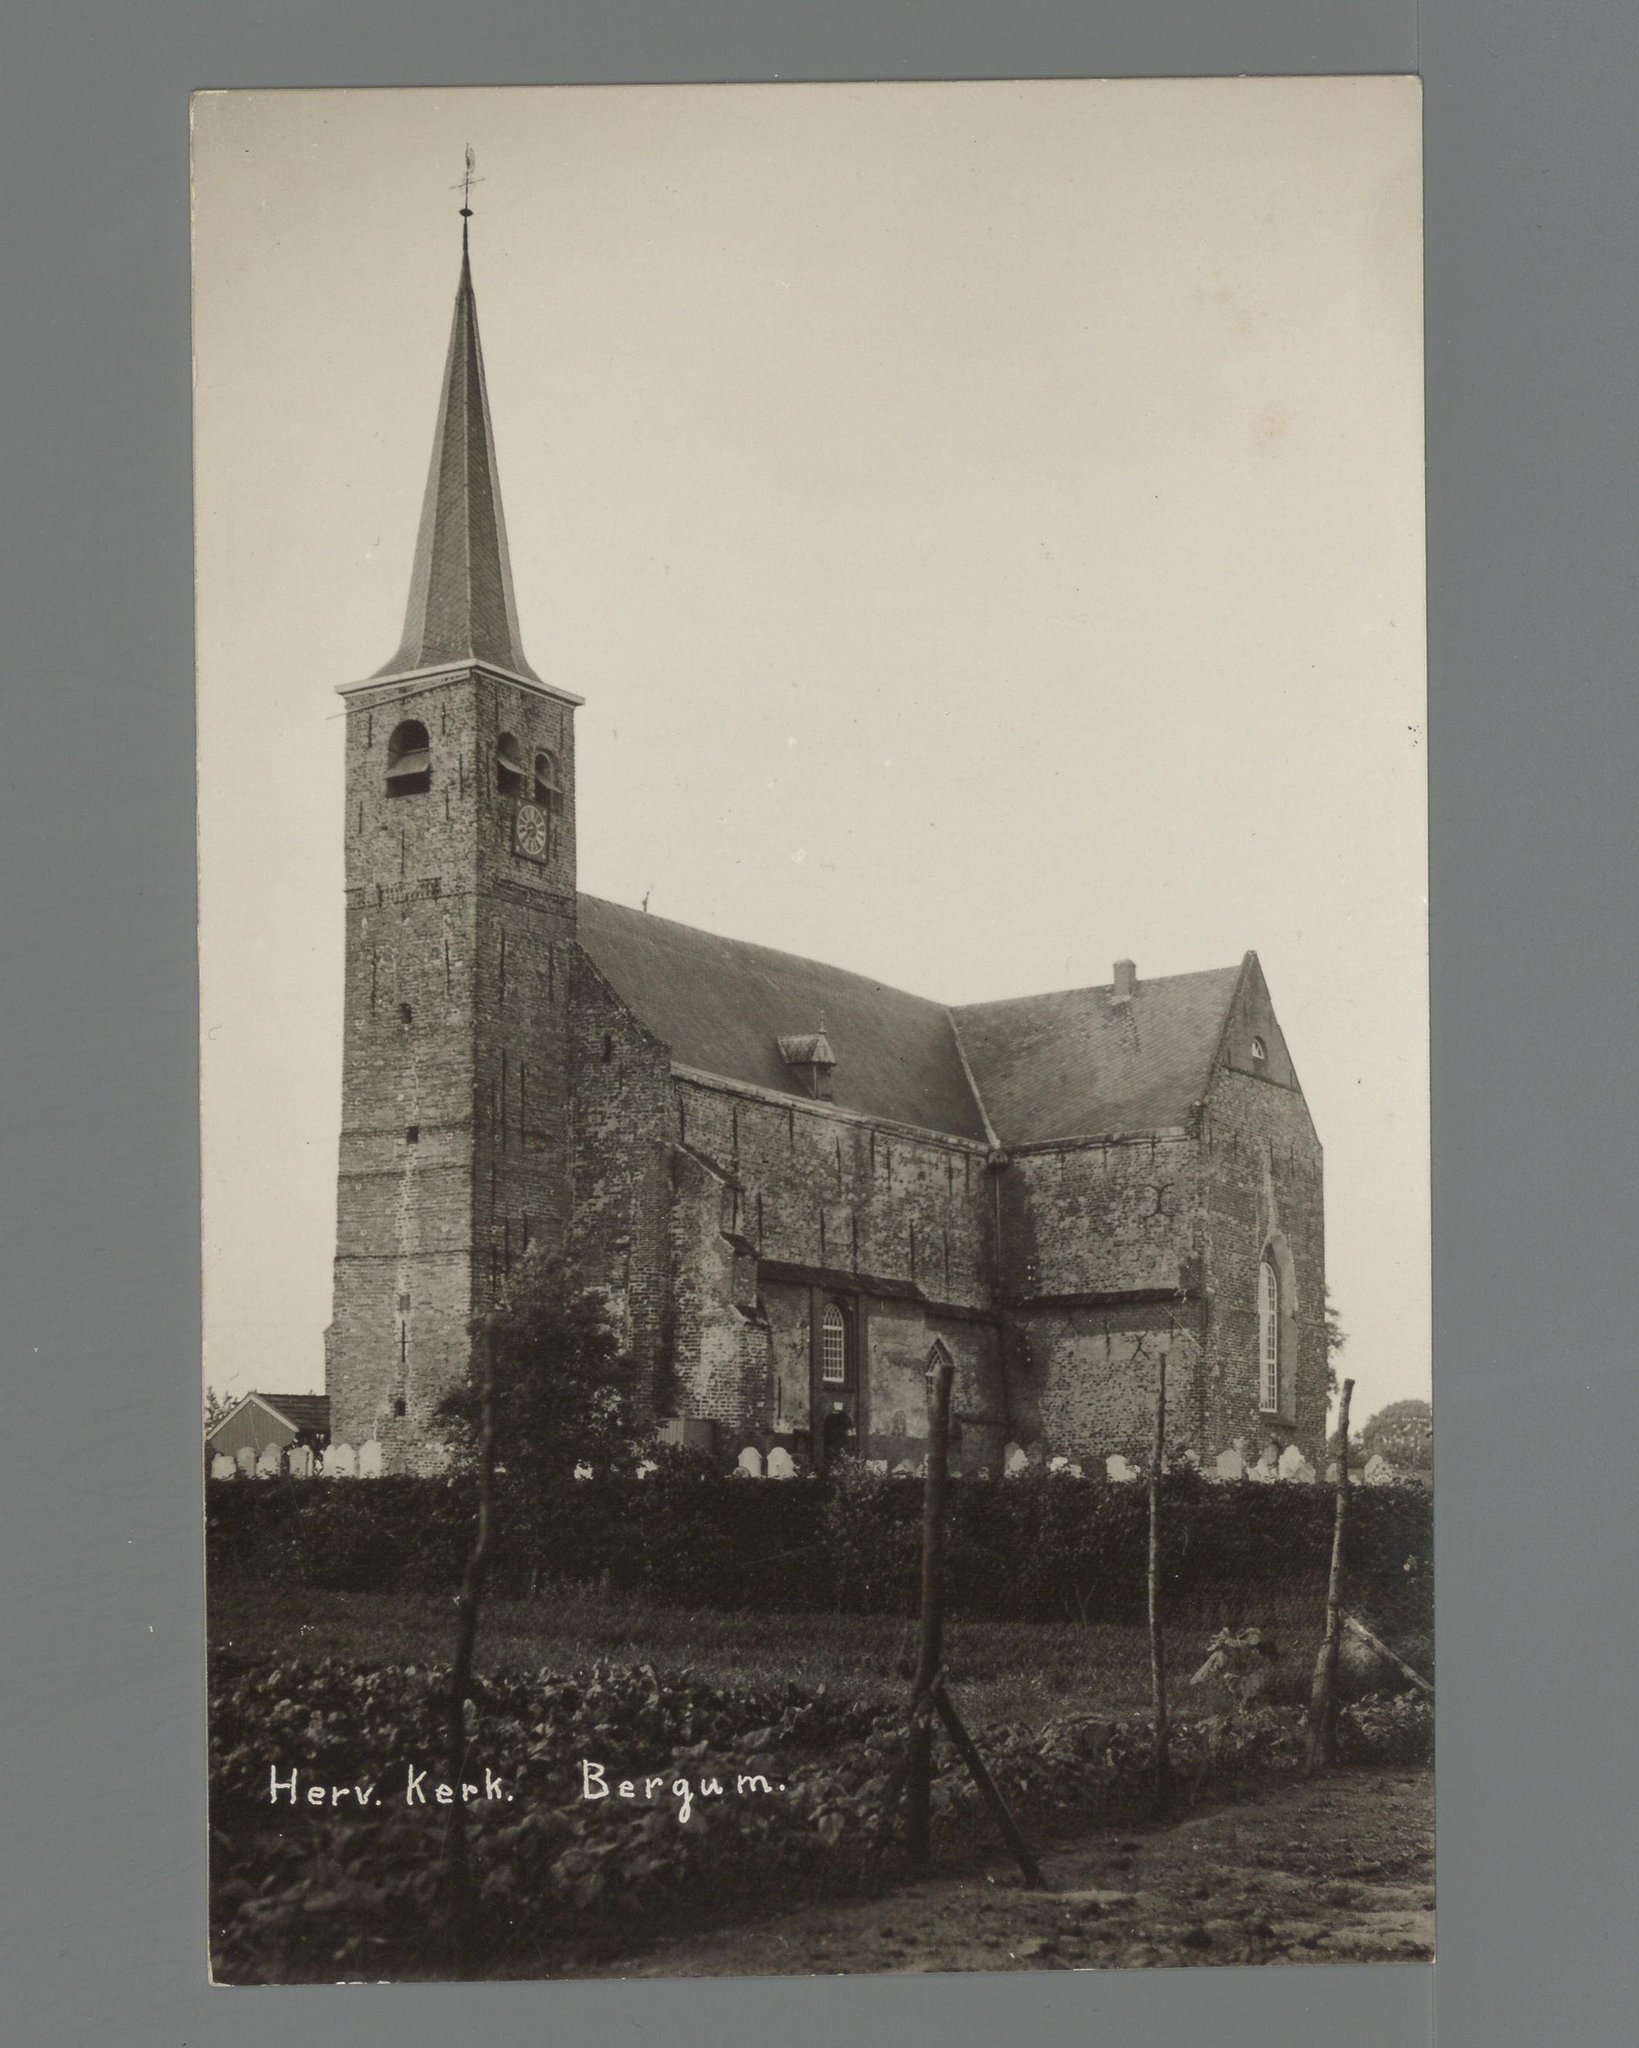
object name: ansichtkaart, prentbriefkaart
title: Herv. Kerk. Bergum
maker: Anonymous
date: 1905-1930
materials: paper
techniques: gelatin silver print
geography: bergum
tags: church (exterior)